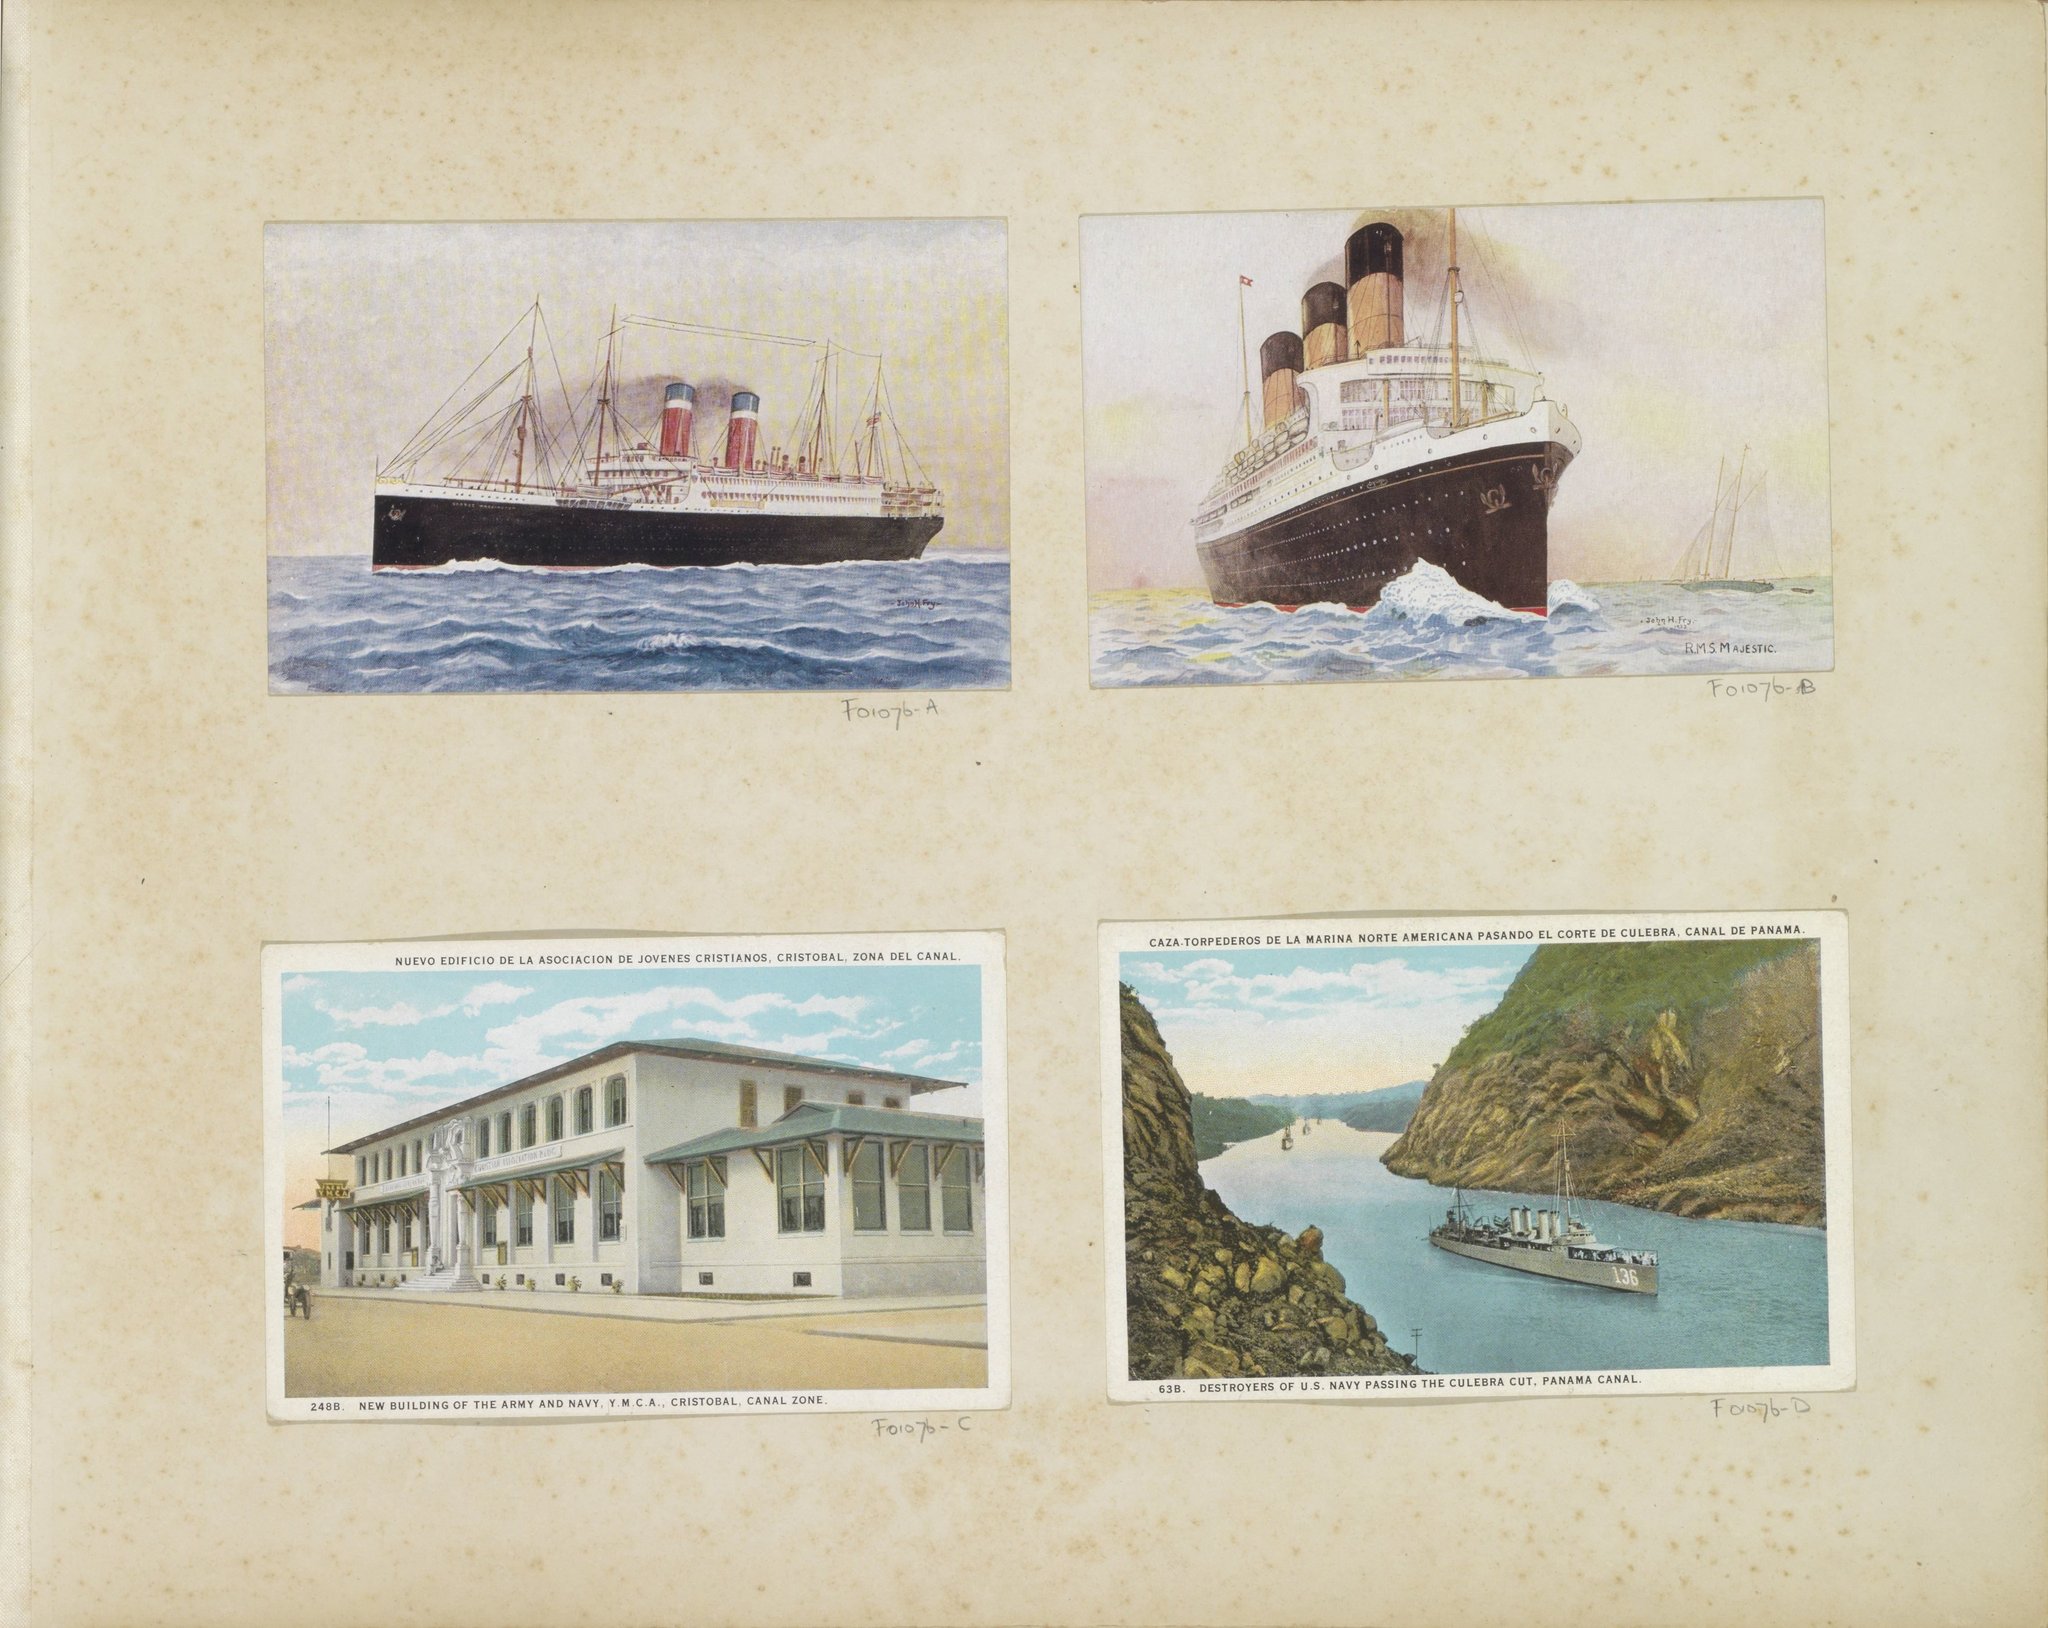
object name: ansichtkaart, prentbriefkaart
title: New building of the army and navy, Y.M.C.A., Cristobal, Canal zone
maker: Anonymous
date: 1920-1940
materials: cardboard, paper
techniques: autotype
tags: exterior ~ representation of a building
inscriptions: number: ‘248b’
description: Onderdeel van Album met foto's van spoorwegen in Nederlands-Indië en prentbriefkaarten.